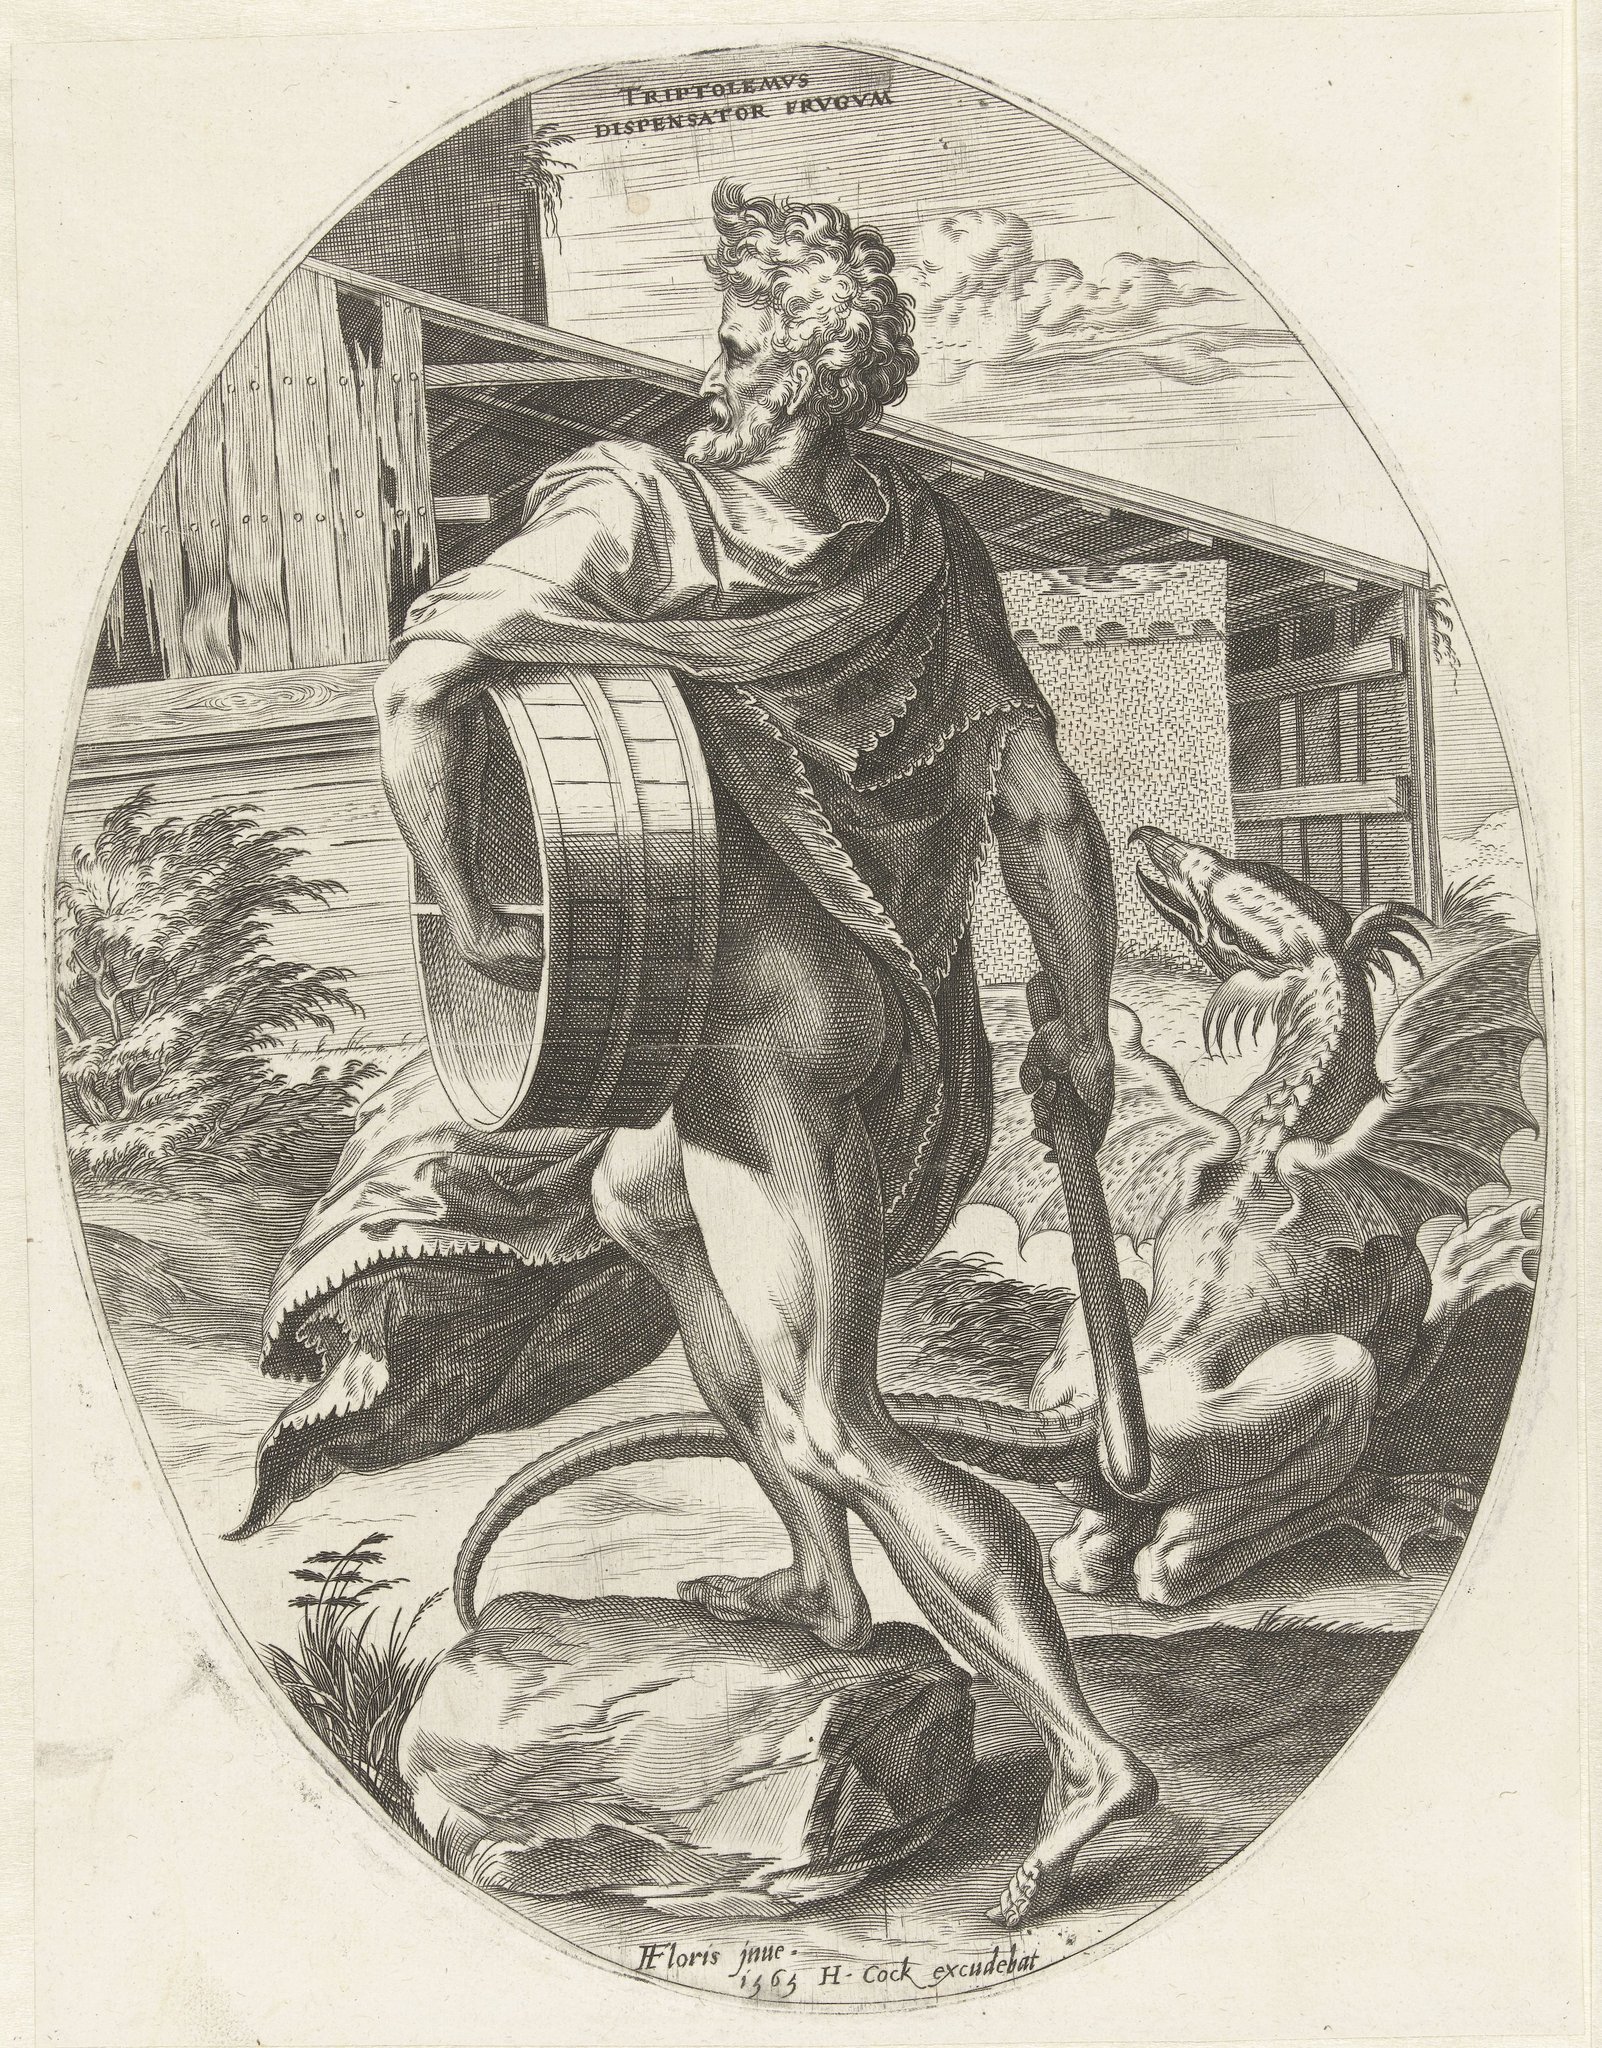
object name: print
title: Goden van de landbouw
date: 1565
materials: paper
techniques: engraving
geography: antwerp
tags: (story of) triptolemus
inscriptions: collector's mark: Lugt 2542, collector's mark: Lugt 1379, collector's mark: Lugt 2228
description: Triptolemus, hulpje van Ceres de godin van de akkerbouw, loopt met een zeef en een dorsvlegel naar een schuur. Een draak staat naast hem.